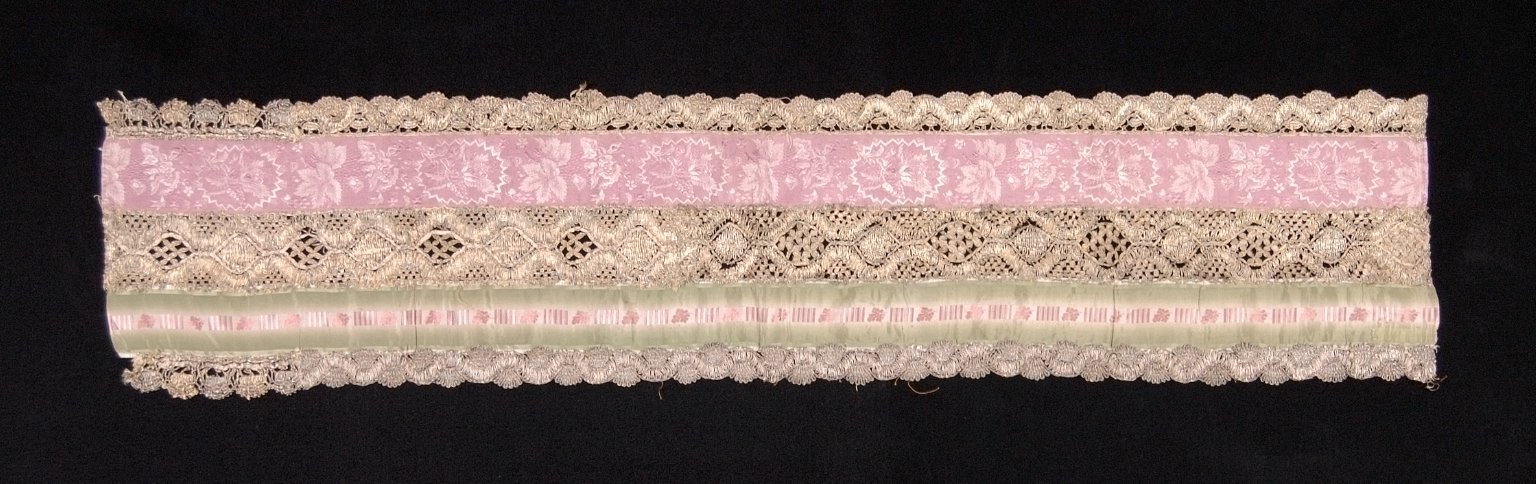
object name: border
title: Towel border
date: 1840-1870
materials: silk